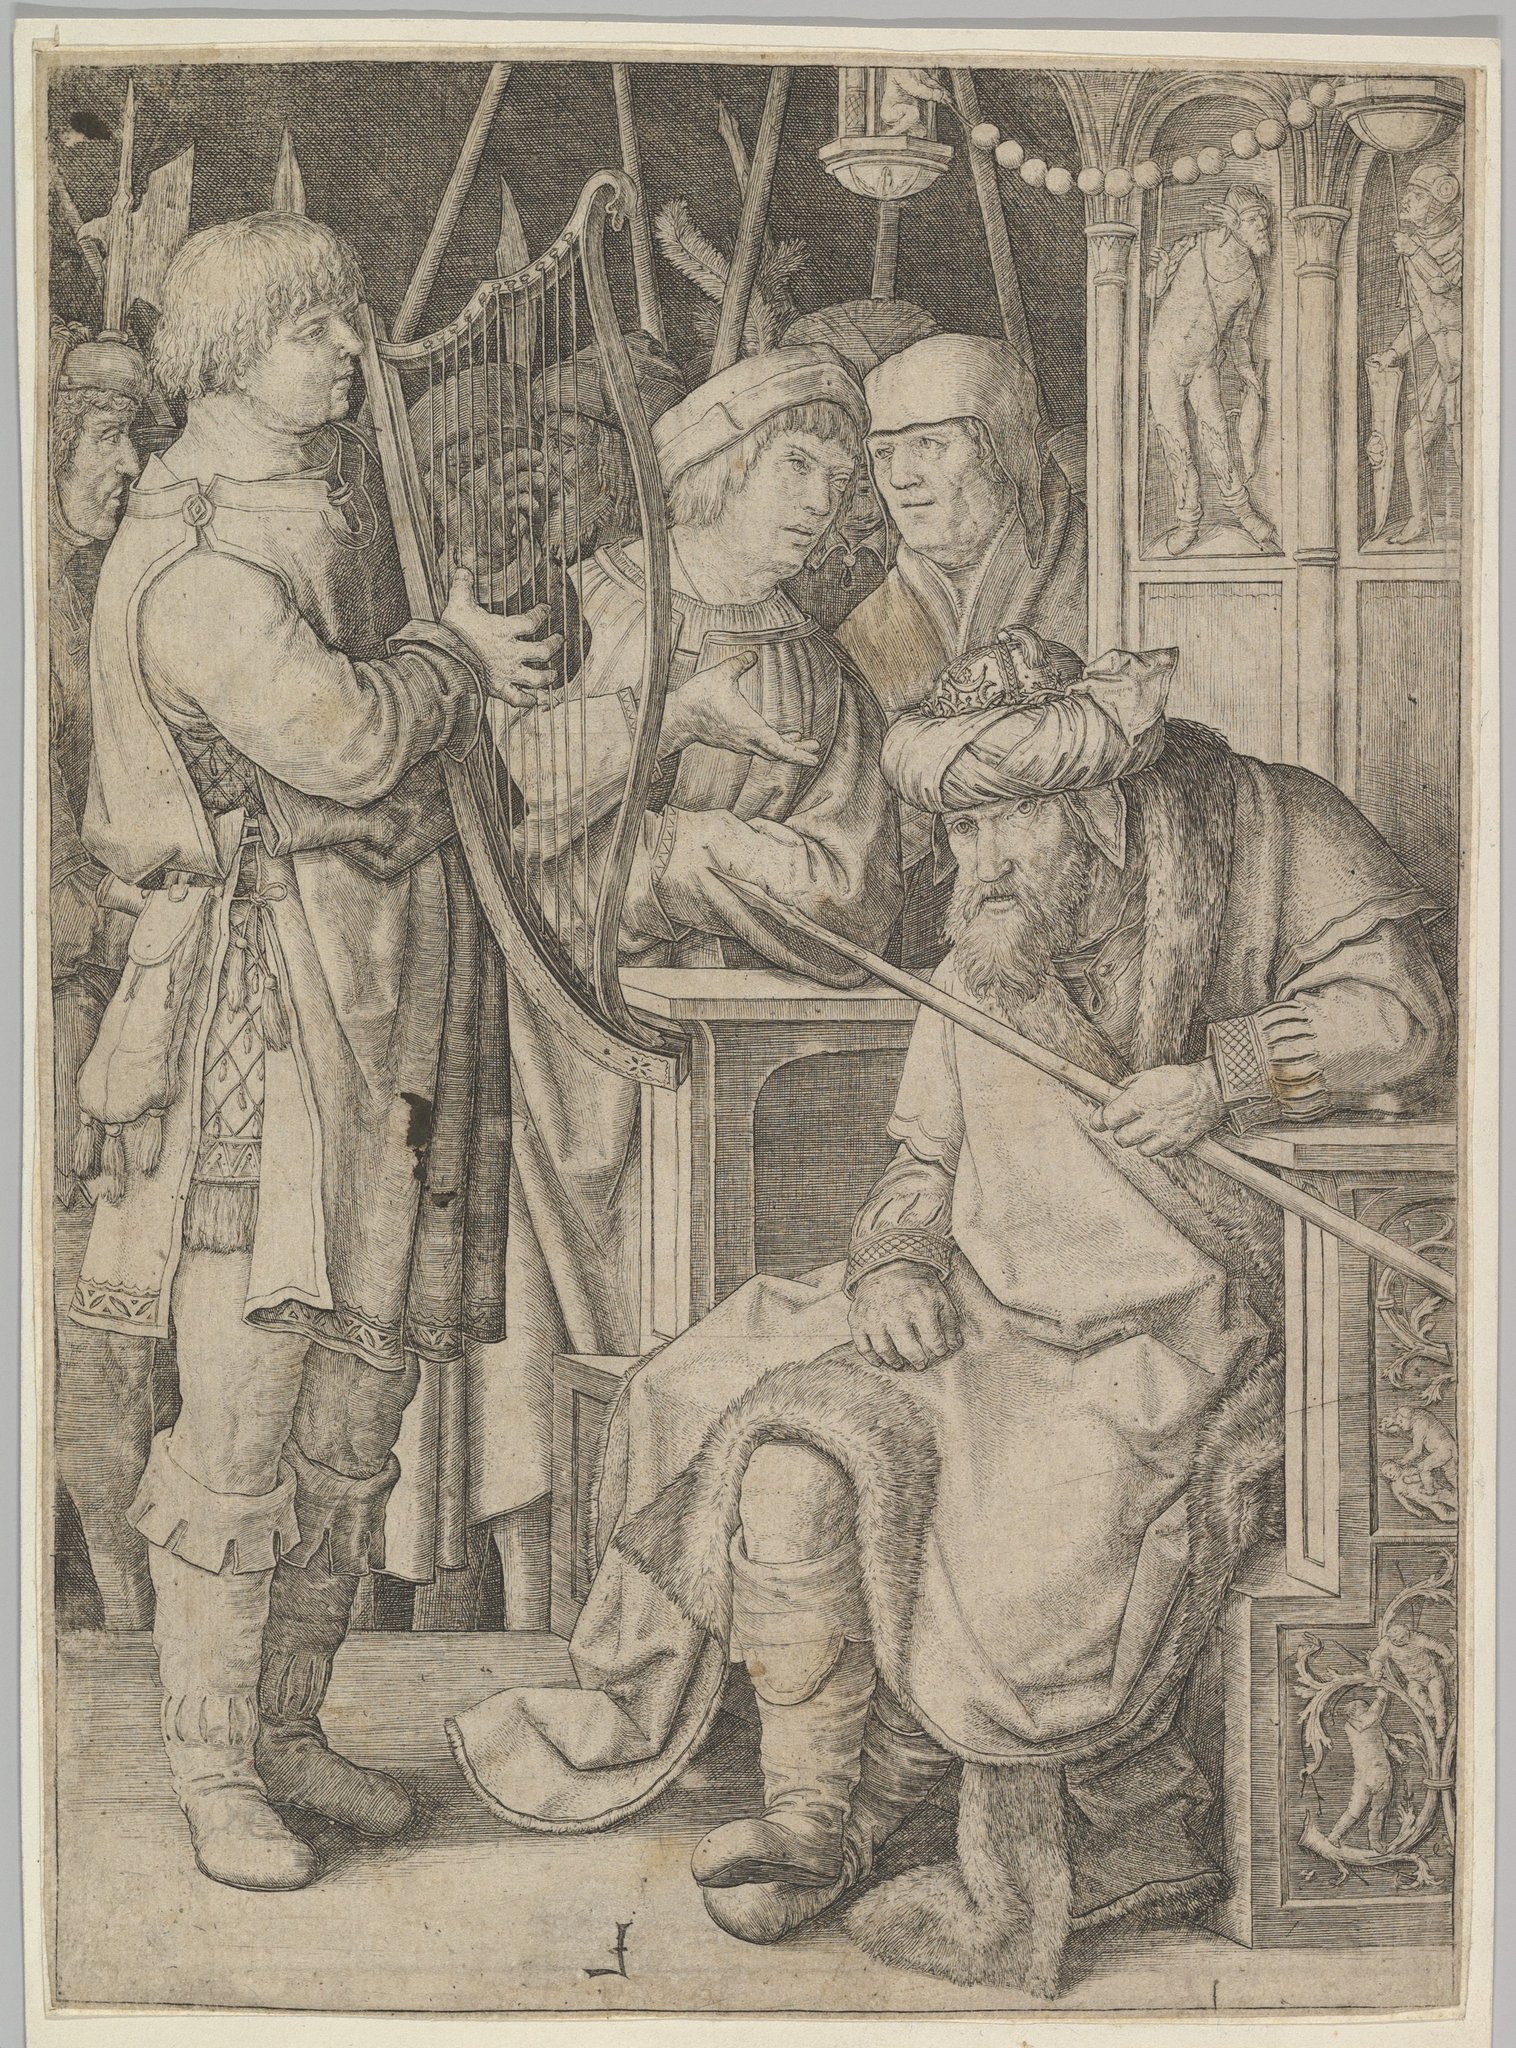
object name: print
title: David Playing the Harp Before Saul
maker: lucas van leyden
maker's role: artist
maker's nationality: netherlandish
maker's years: 1494-1533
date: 1508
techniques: engraving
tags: kings,men,harps,david